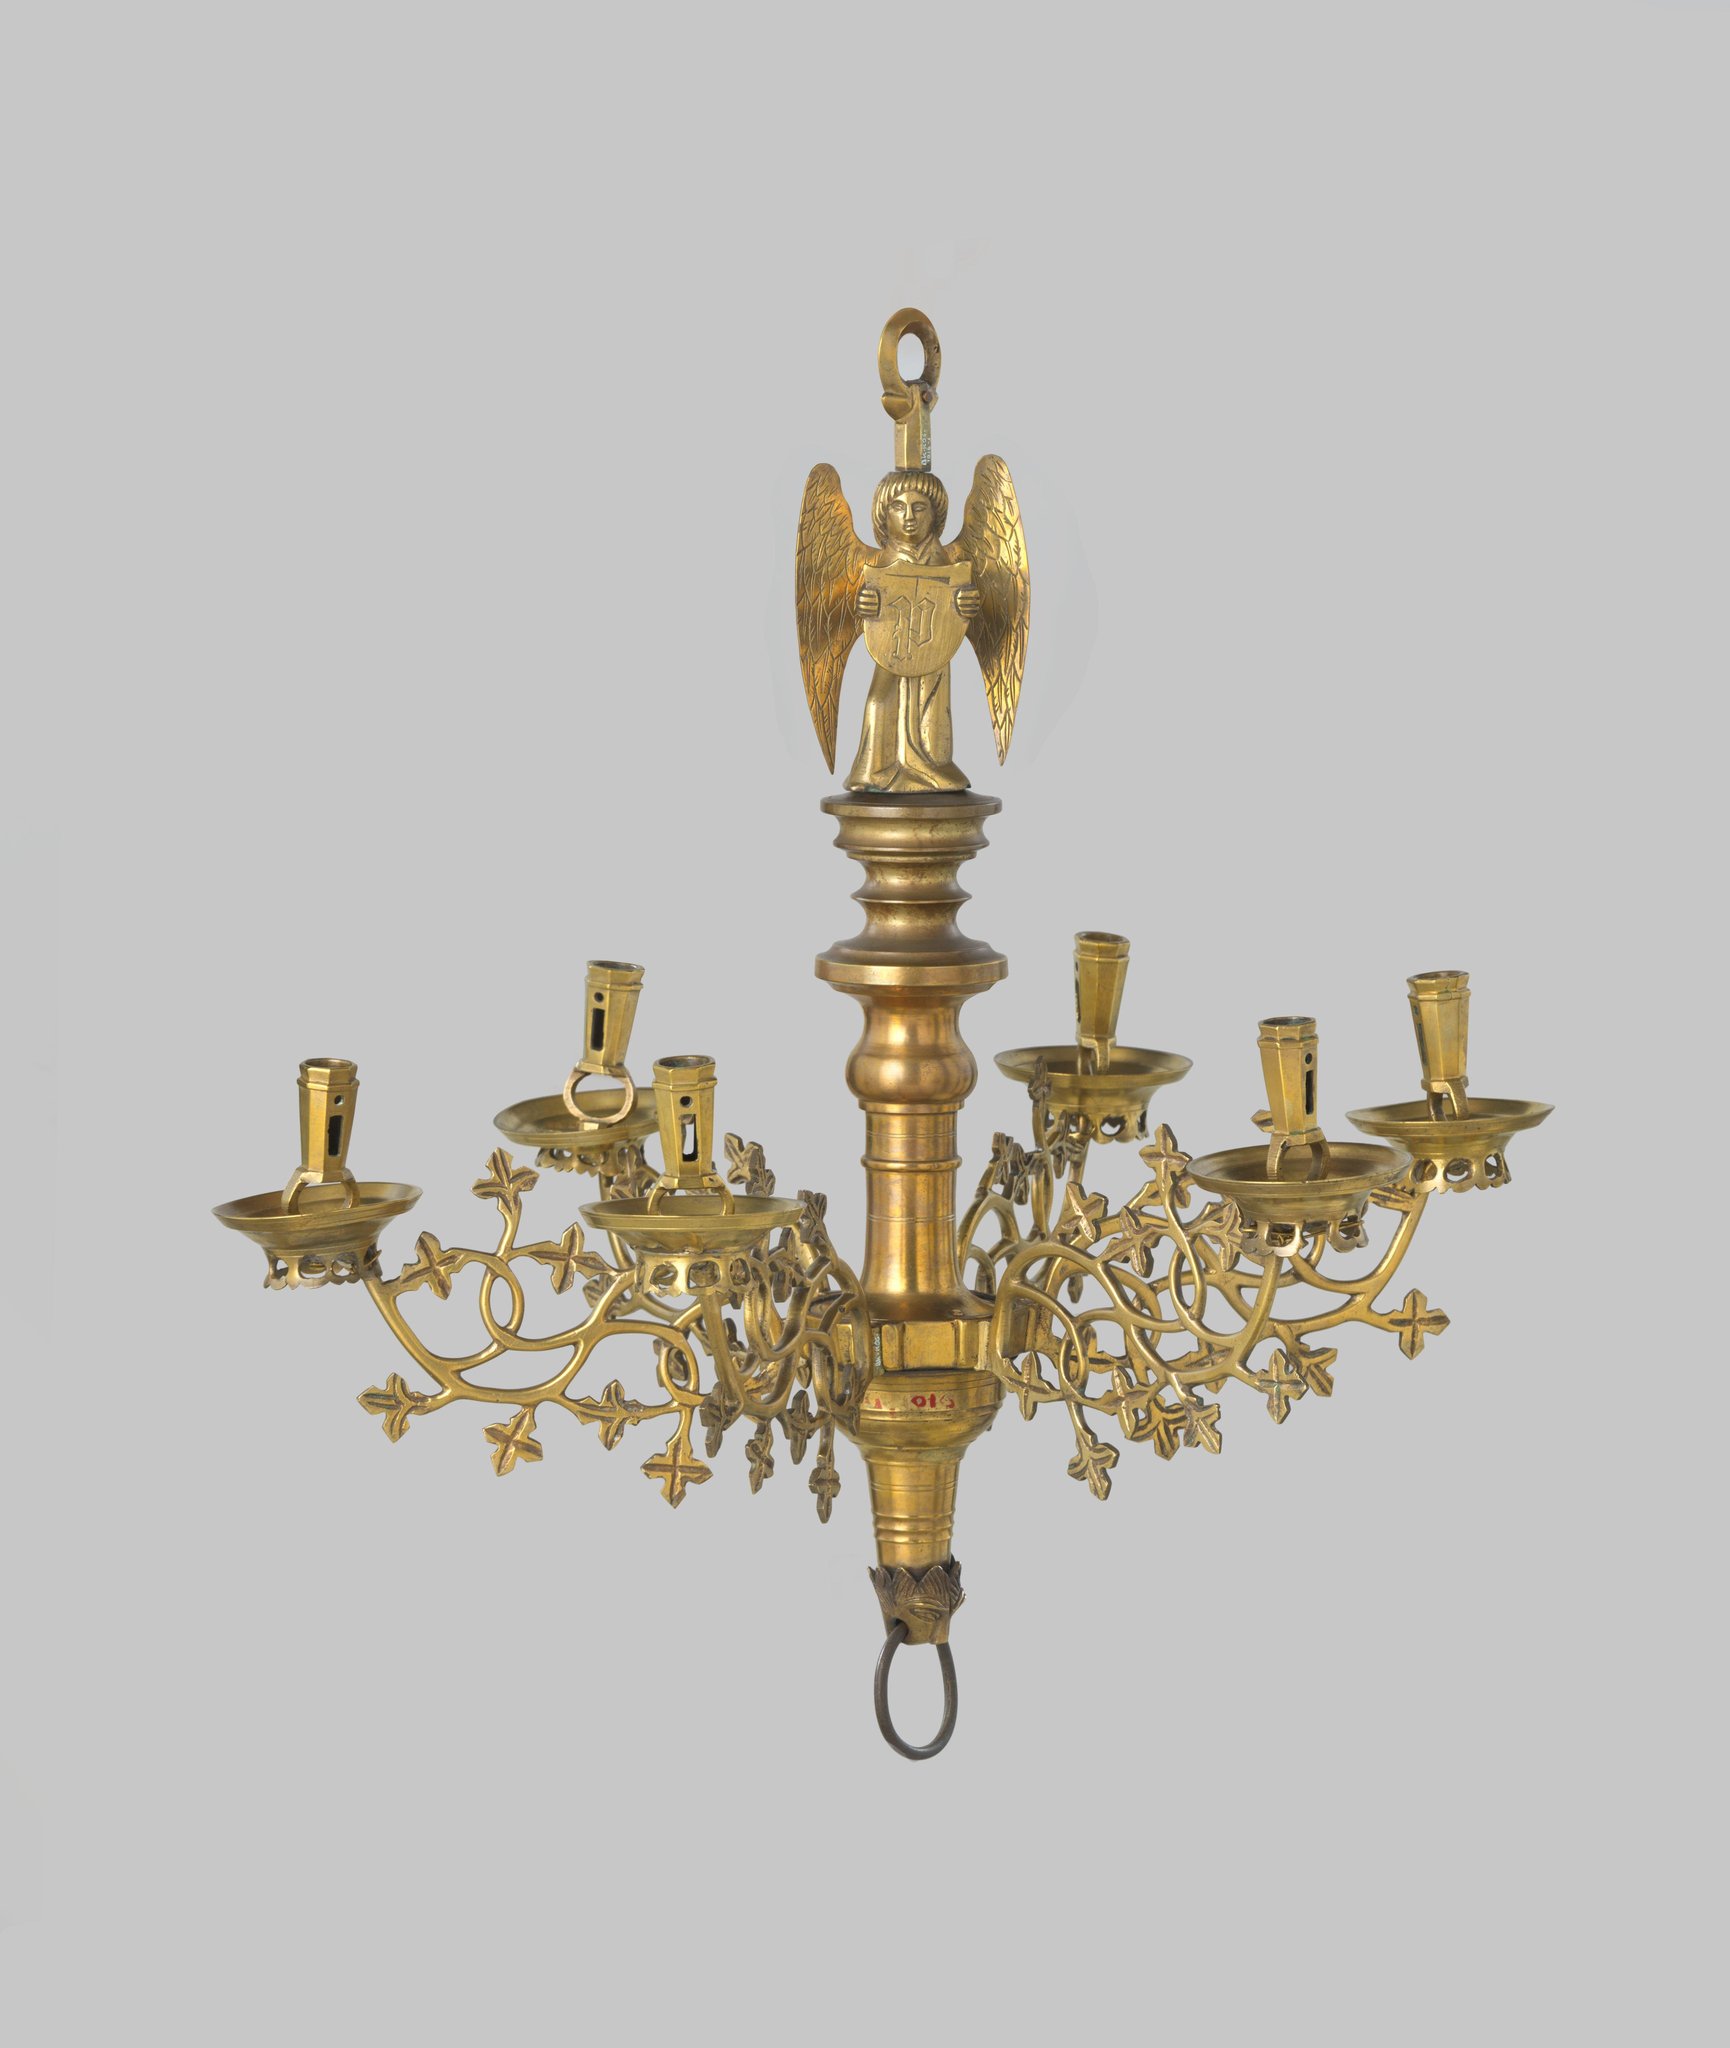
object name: chandelier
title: Kaarsenkroon met zes armen en engel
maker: Anonymous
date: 1825-1875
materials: brass, iron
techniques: casting, forging, riveted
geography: western europe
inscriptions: inscription: ‘P’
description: Het voorwerp bestaat uit een ijzeren stang en de volgende gegoten delen: de hangring (die aan de stang is geklonken), de engel, het wapenschild met de handjes (die aldaar aan de armen zijn geklonken), het uit koperplaat gemaakte deel met de twee vleugels (dat met een pin op de rug van de engel is bevestigd), het bovenste stamdeel, de standring met zes gleuven, het onderste stamdeel, de leeuwenkop (welke vier delen tot een geheel zijn geklonken), de trekring. De geknielde engel houdt een schild op met de letter P in gotisch minuskelschrift. Het bovenste stamdeel is overwegend bol- en holrond geprofileerd en is tevens met twee paar gegroefde ringen versierd. Het onderste stamdeel verjongt zich naar beneden toe en heeft zes paar gegroefde ringen. De S-vormige armen zijn versierd met negen wingerdbladeren, ten dele aan verstrengelde ranken. De ronde vetvangers zijn voorzien van ajour bewerkte gekartelde versieringen aan de onderzijde. Zij zijn bevestigd met achtvlakkige voor en achter geperforeerde kaarsenhouders op verticale ringvormige voeten, die op de armen zijn geschroefd.